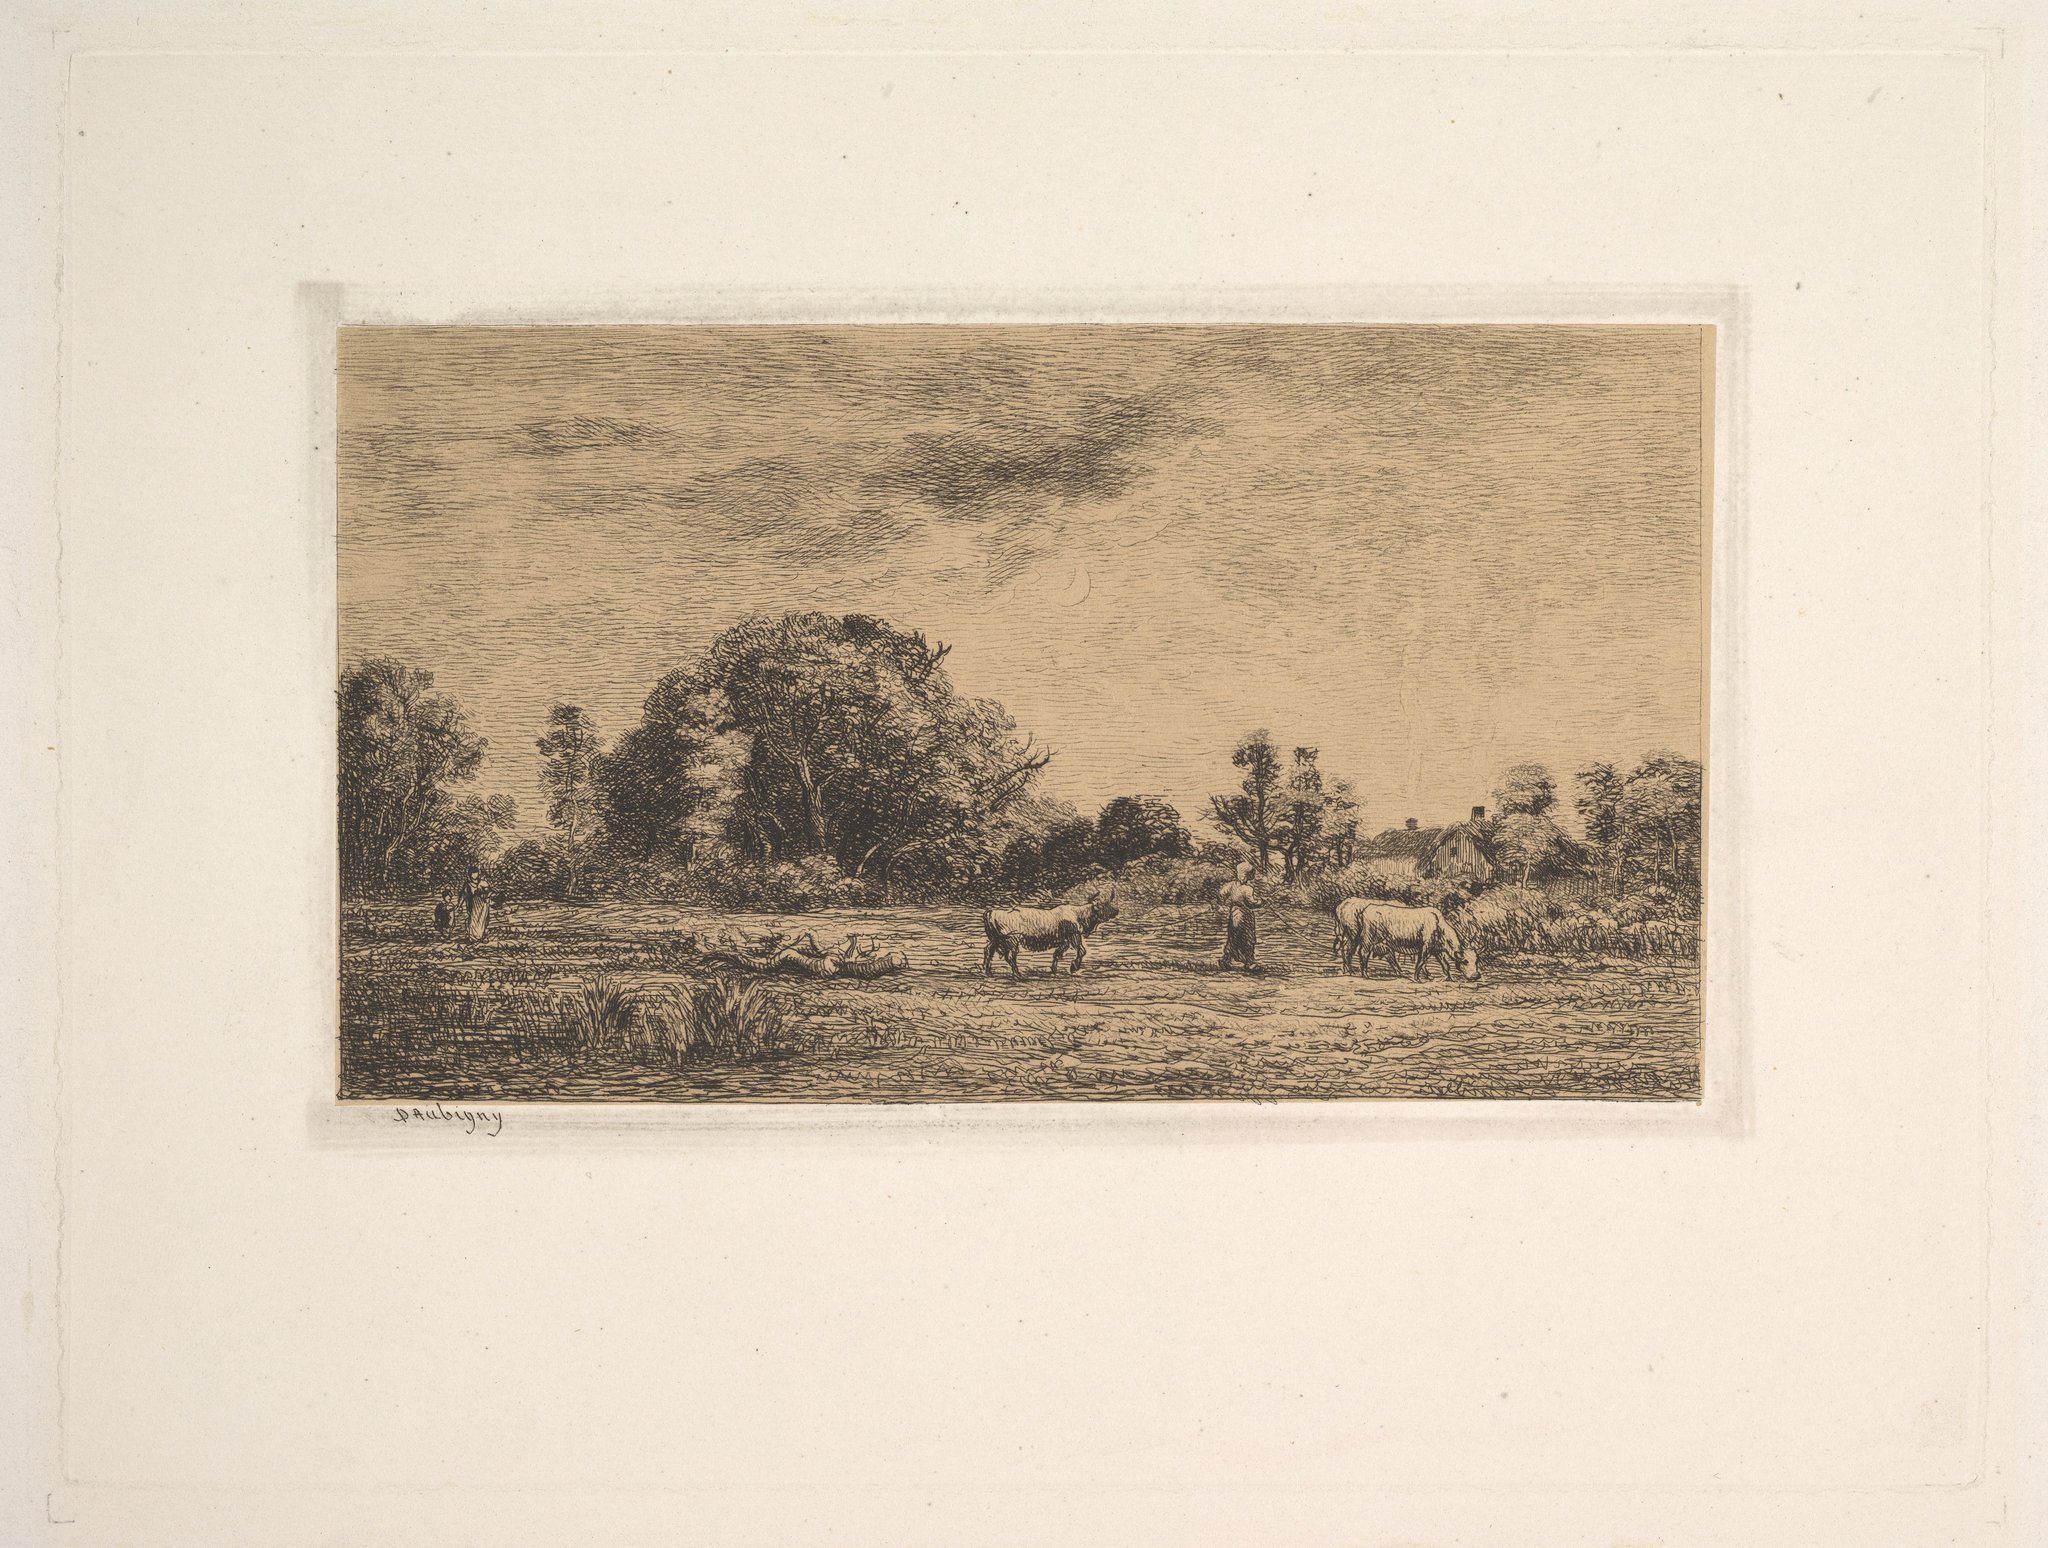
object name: print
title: Moonrise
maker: charles-françois daubigny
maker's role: artist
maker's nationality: french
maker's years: 1817-1878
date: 1861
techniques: etching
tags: human figures,animals,trees